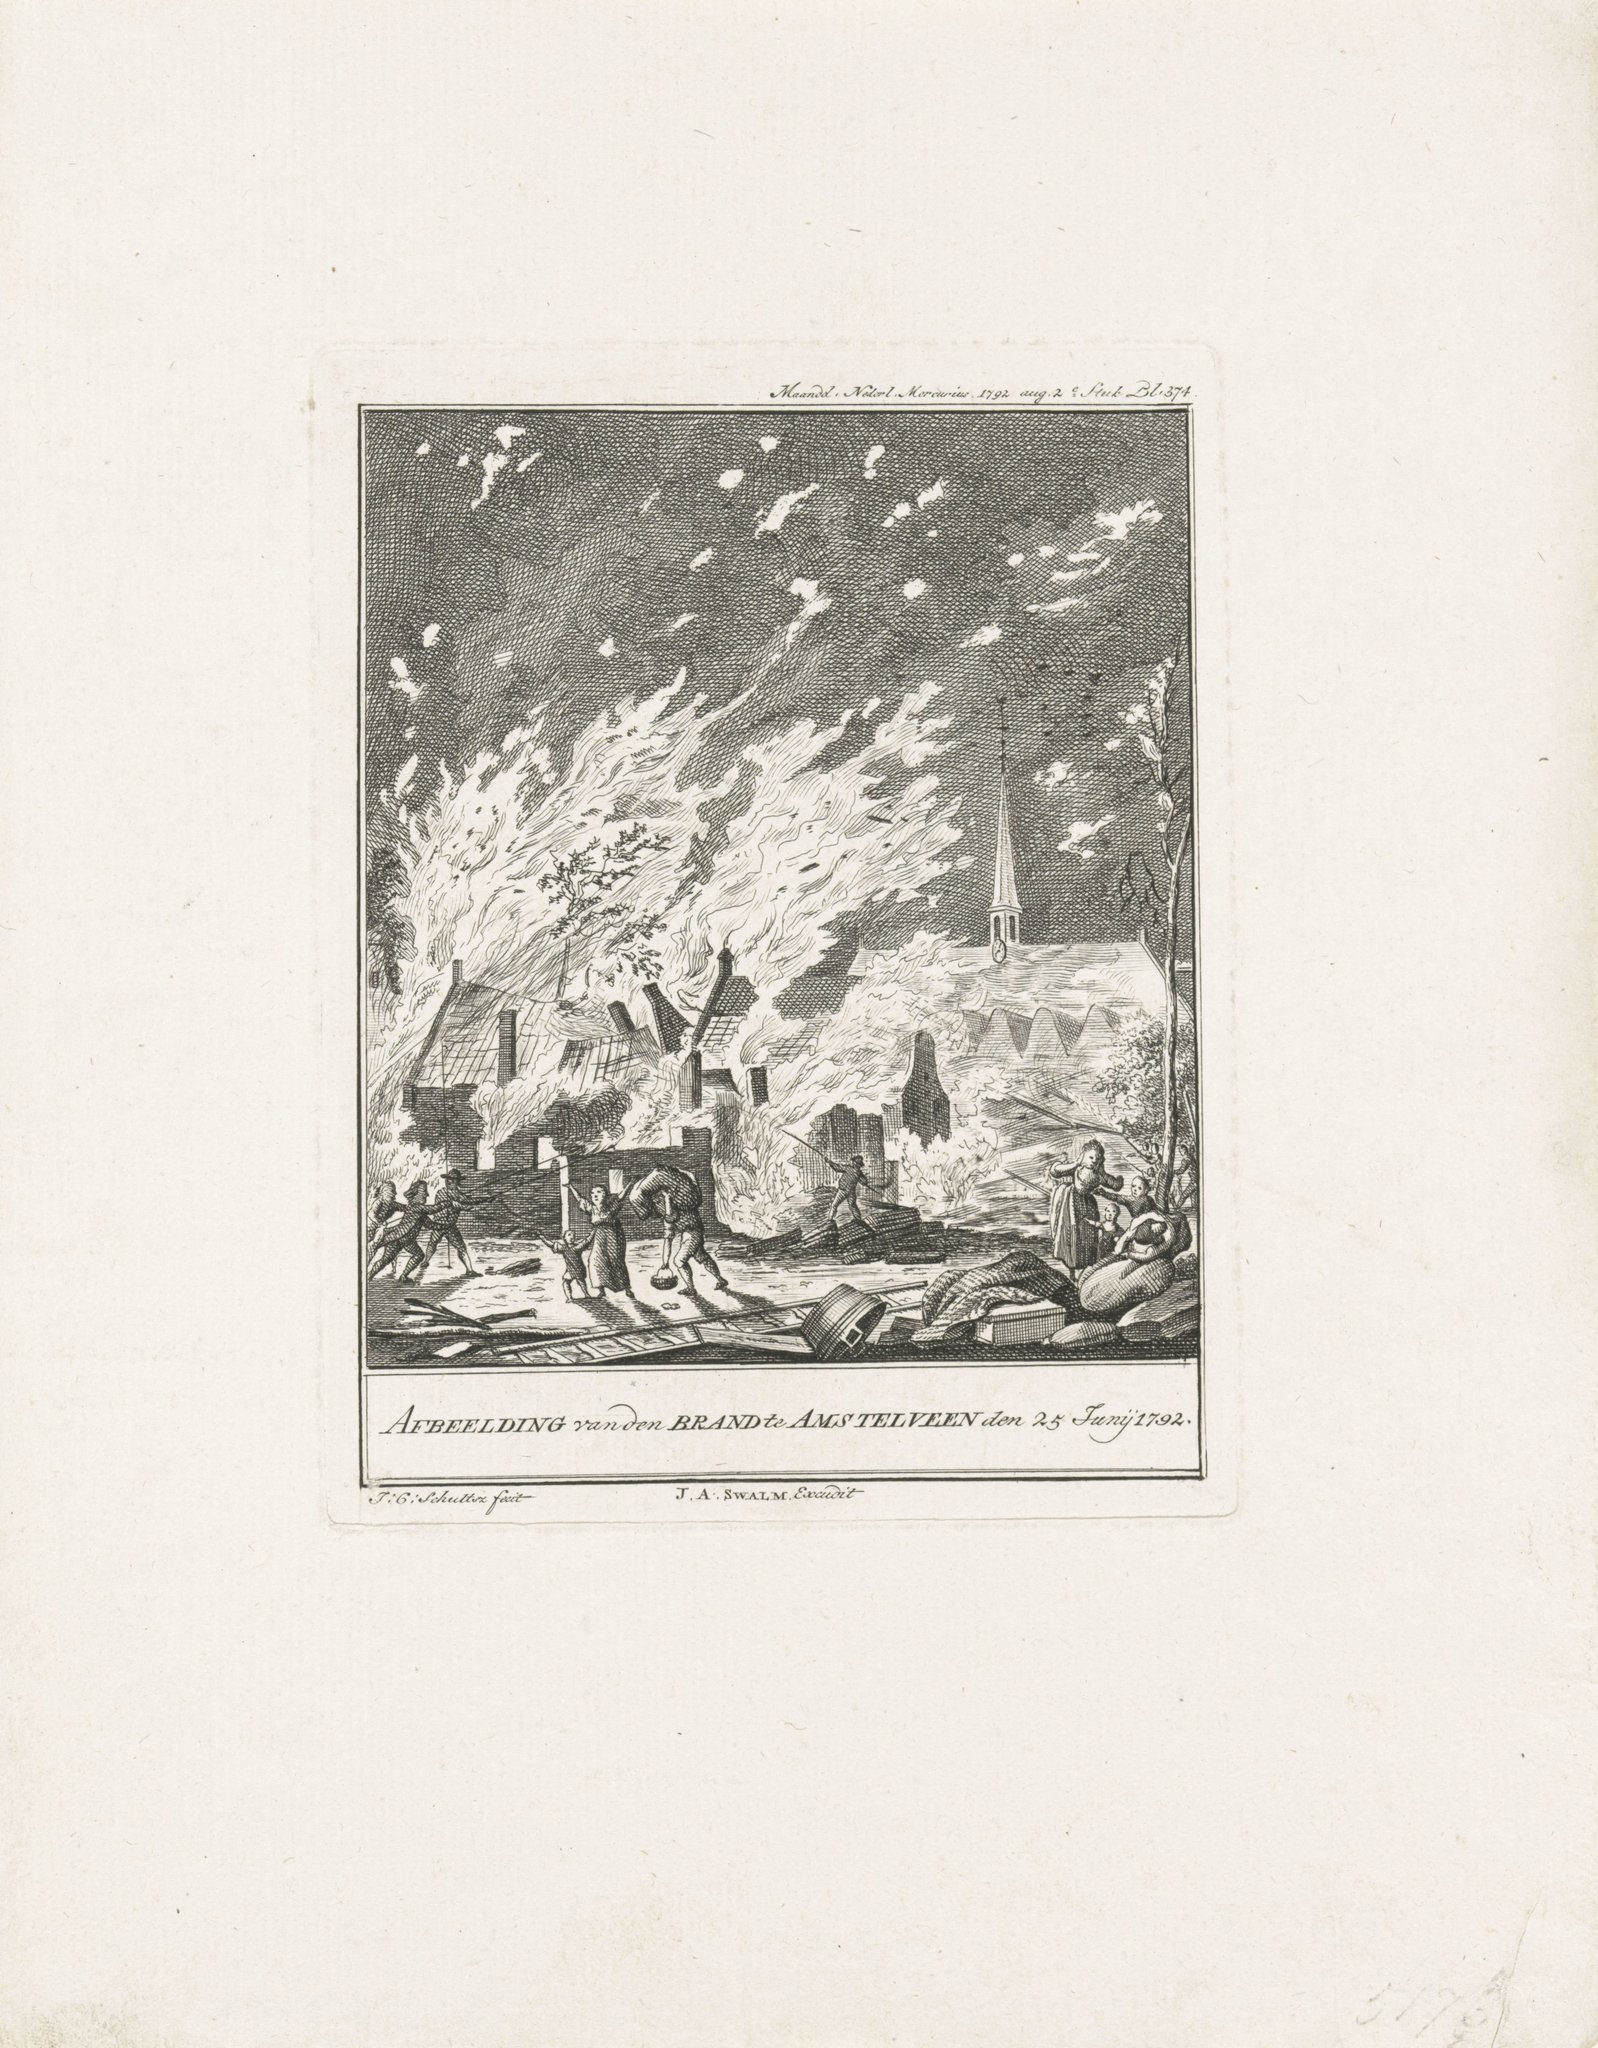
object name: print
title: Brand te Amstelveen, 1792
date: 1793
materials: paper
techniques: engraving, etching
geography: amsterdam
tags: on fire, ablaze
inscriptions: collector's mark: Lugt 2228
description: Gebruikt als illustratie in: Maandelijkse Nederlandsche Mercurius, Augustus 1792, tweede stuk, p. 374.